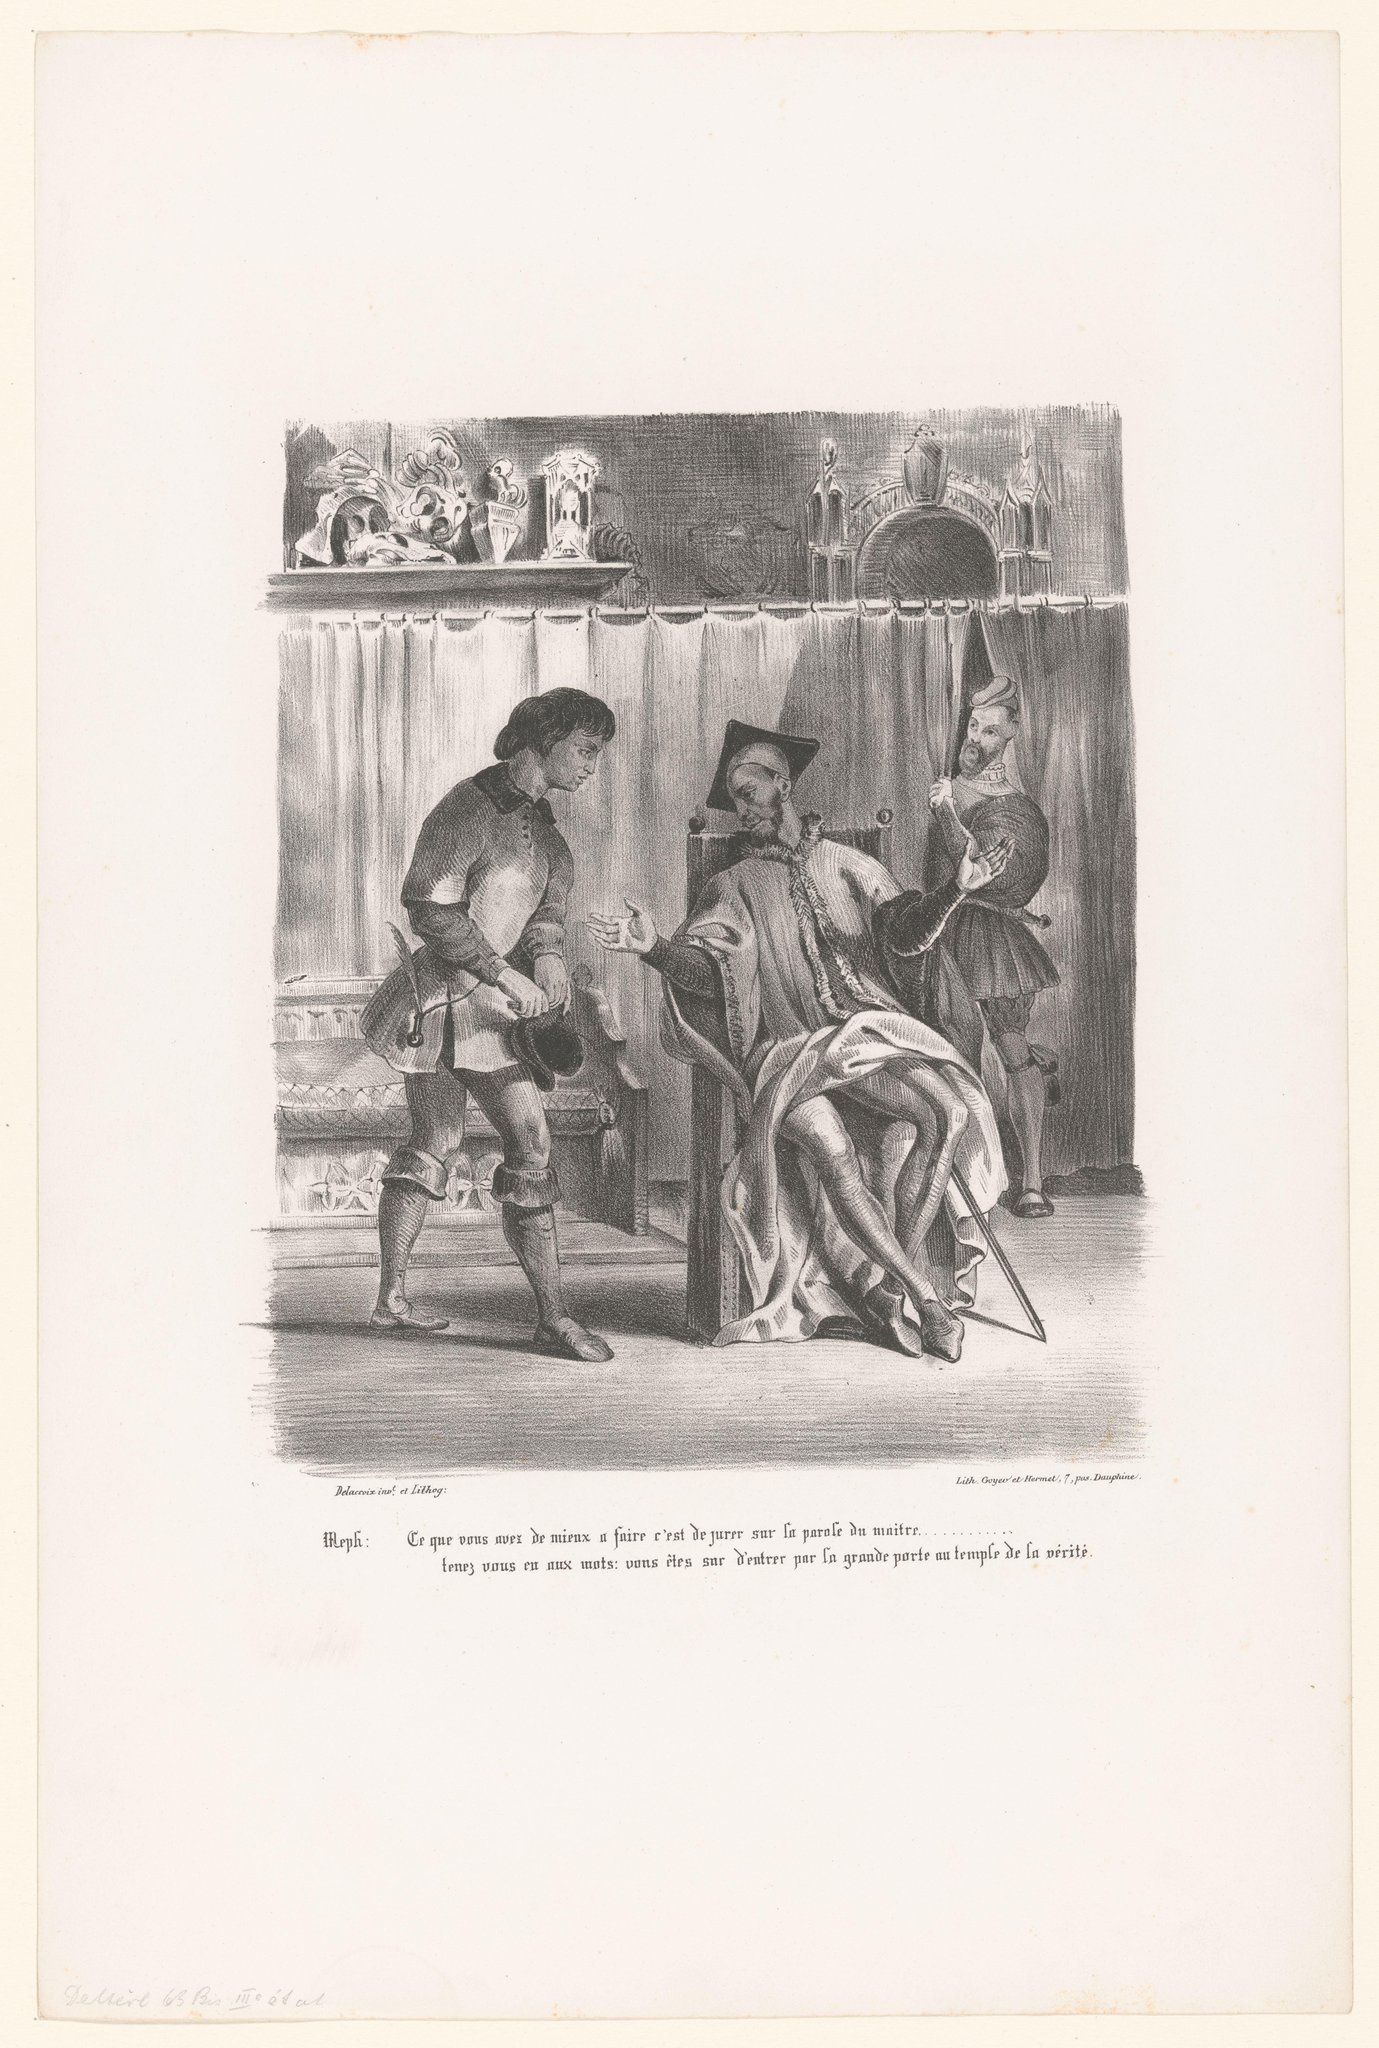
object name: print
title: Meph: Ce que vous avex de mieux à faire (...)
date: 1828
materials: paper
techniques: lithograph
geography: paris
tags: (scenes from) specific works of literature: goethe, faust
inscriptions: collector's mark: Lugt 964, collector's mark: Lugt 2228a